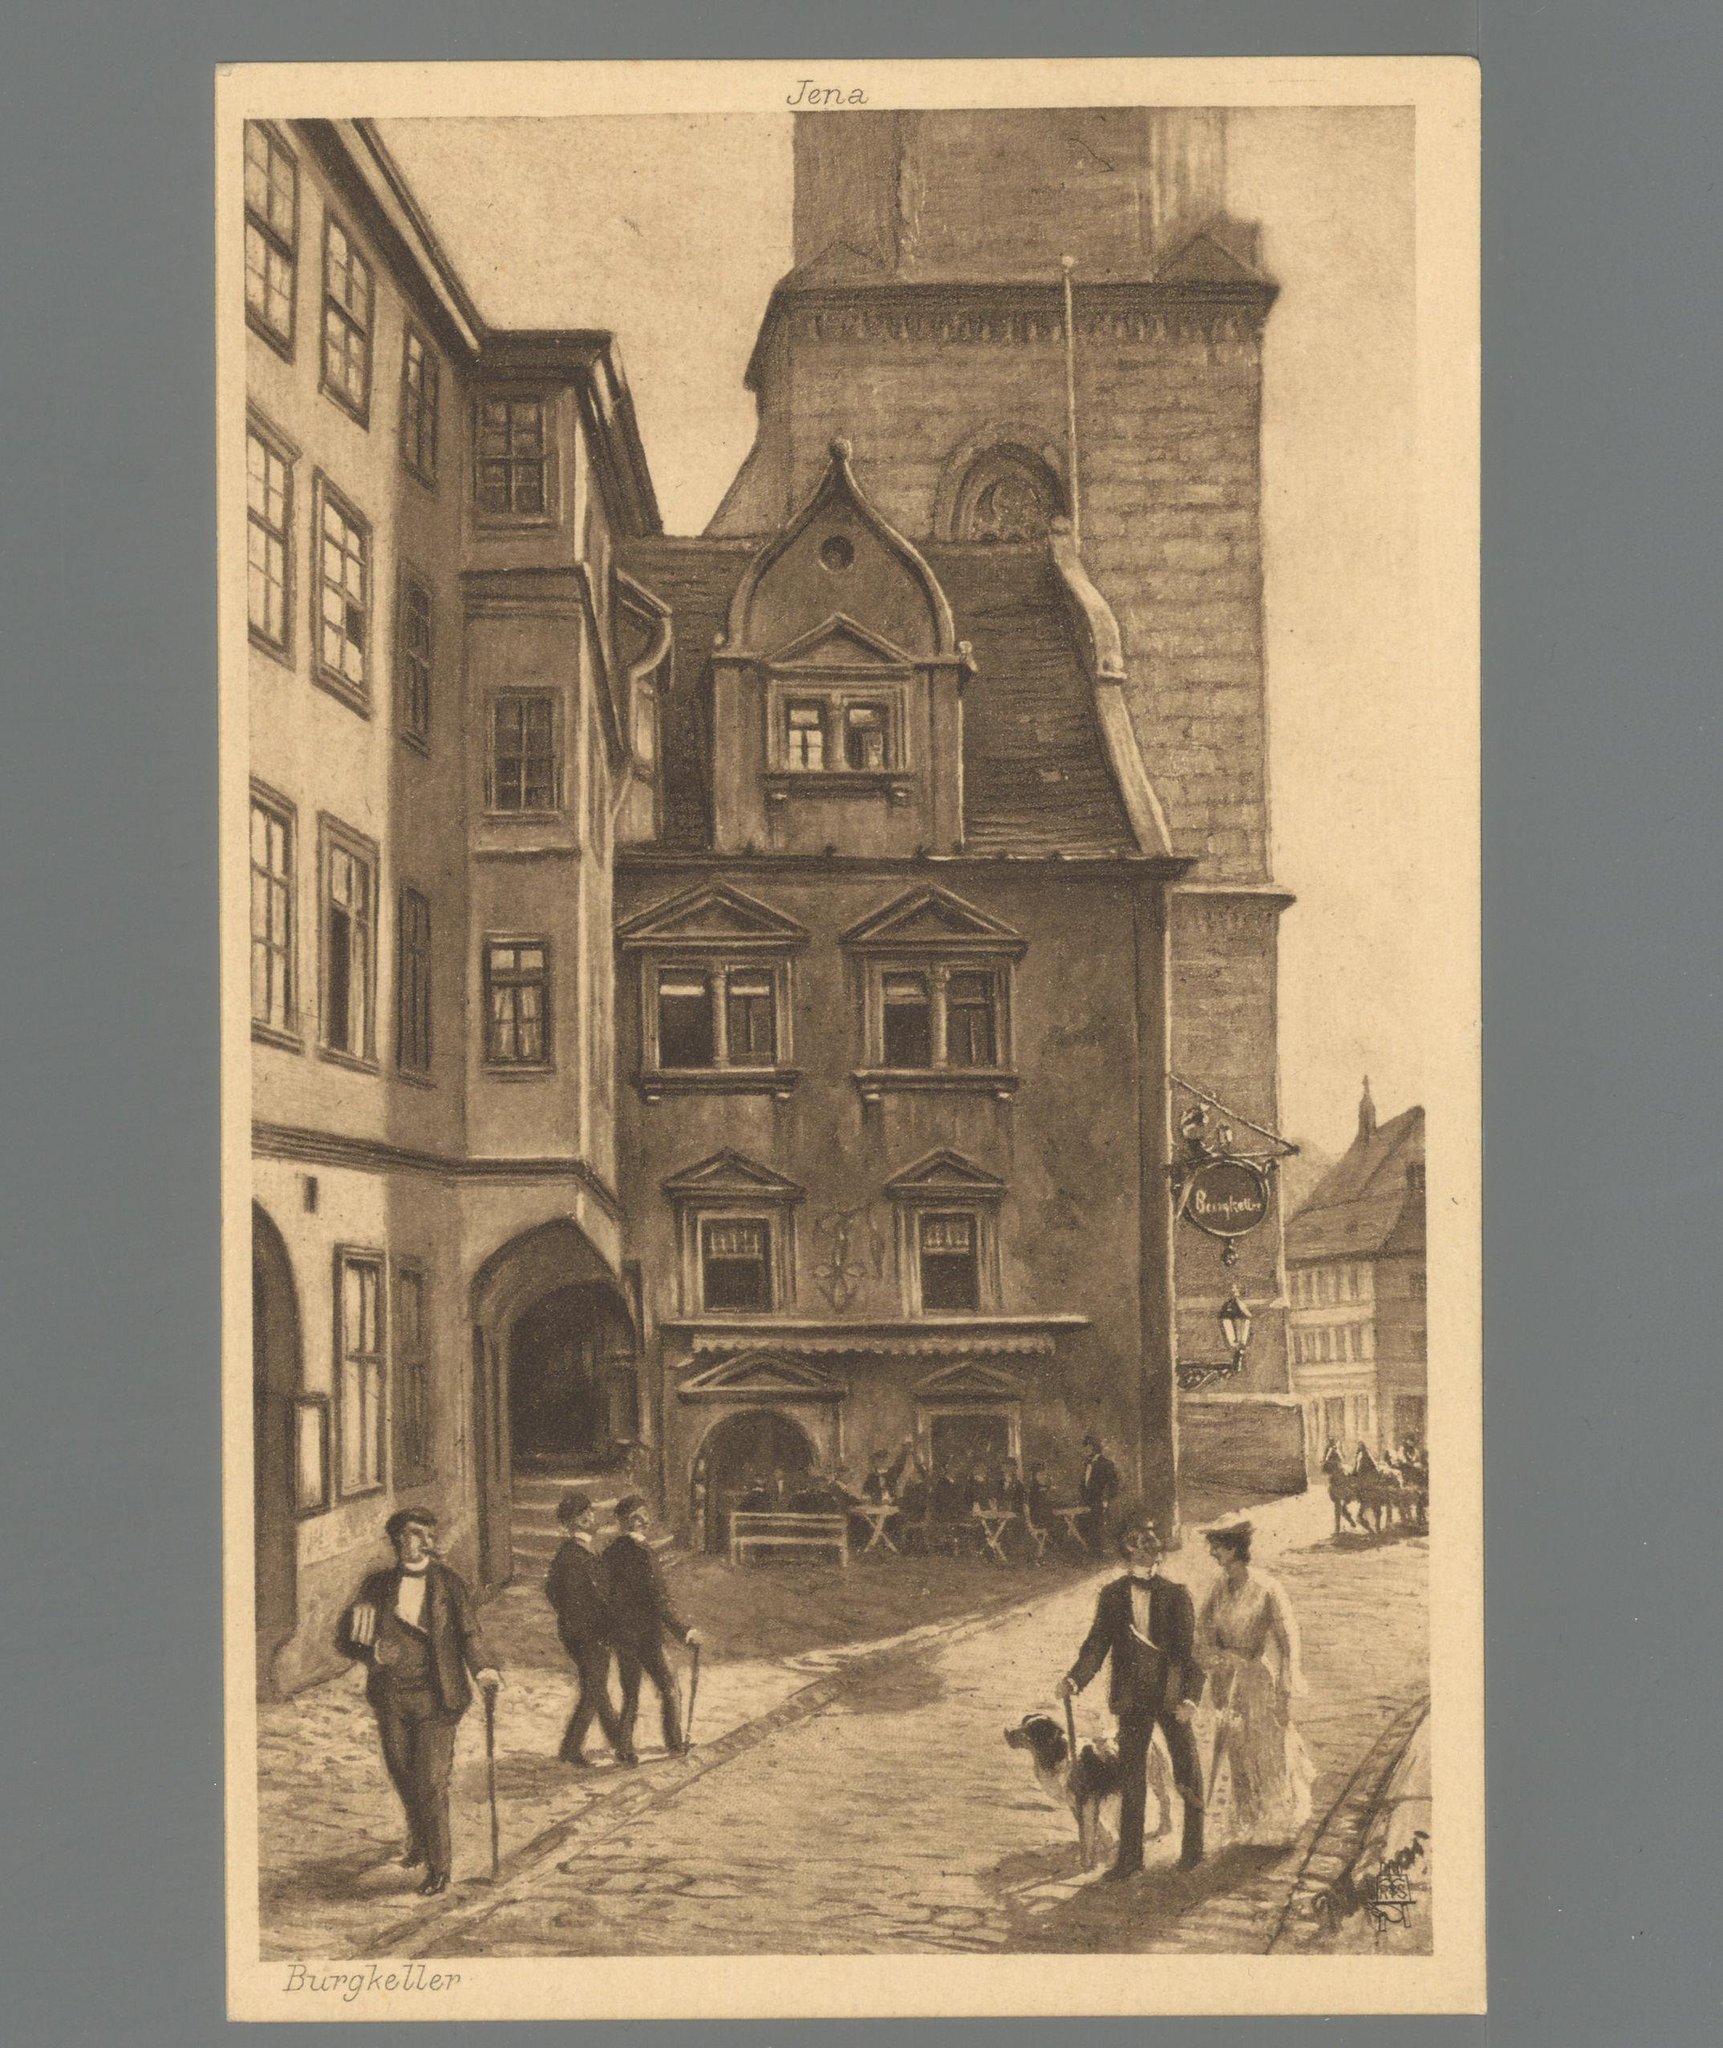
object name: reproduction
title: Jena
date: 1905-1930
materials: cardboard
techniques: rotogravure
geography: berlin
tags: city-view, and landscape with man-made constructions, club (students)